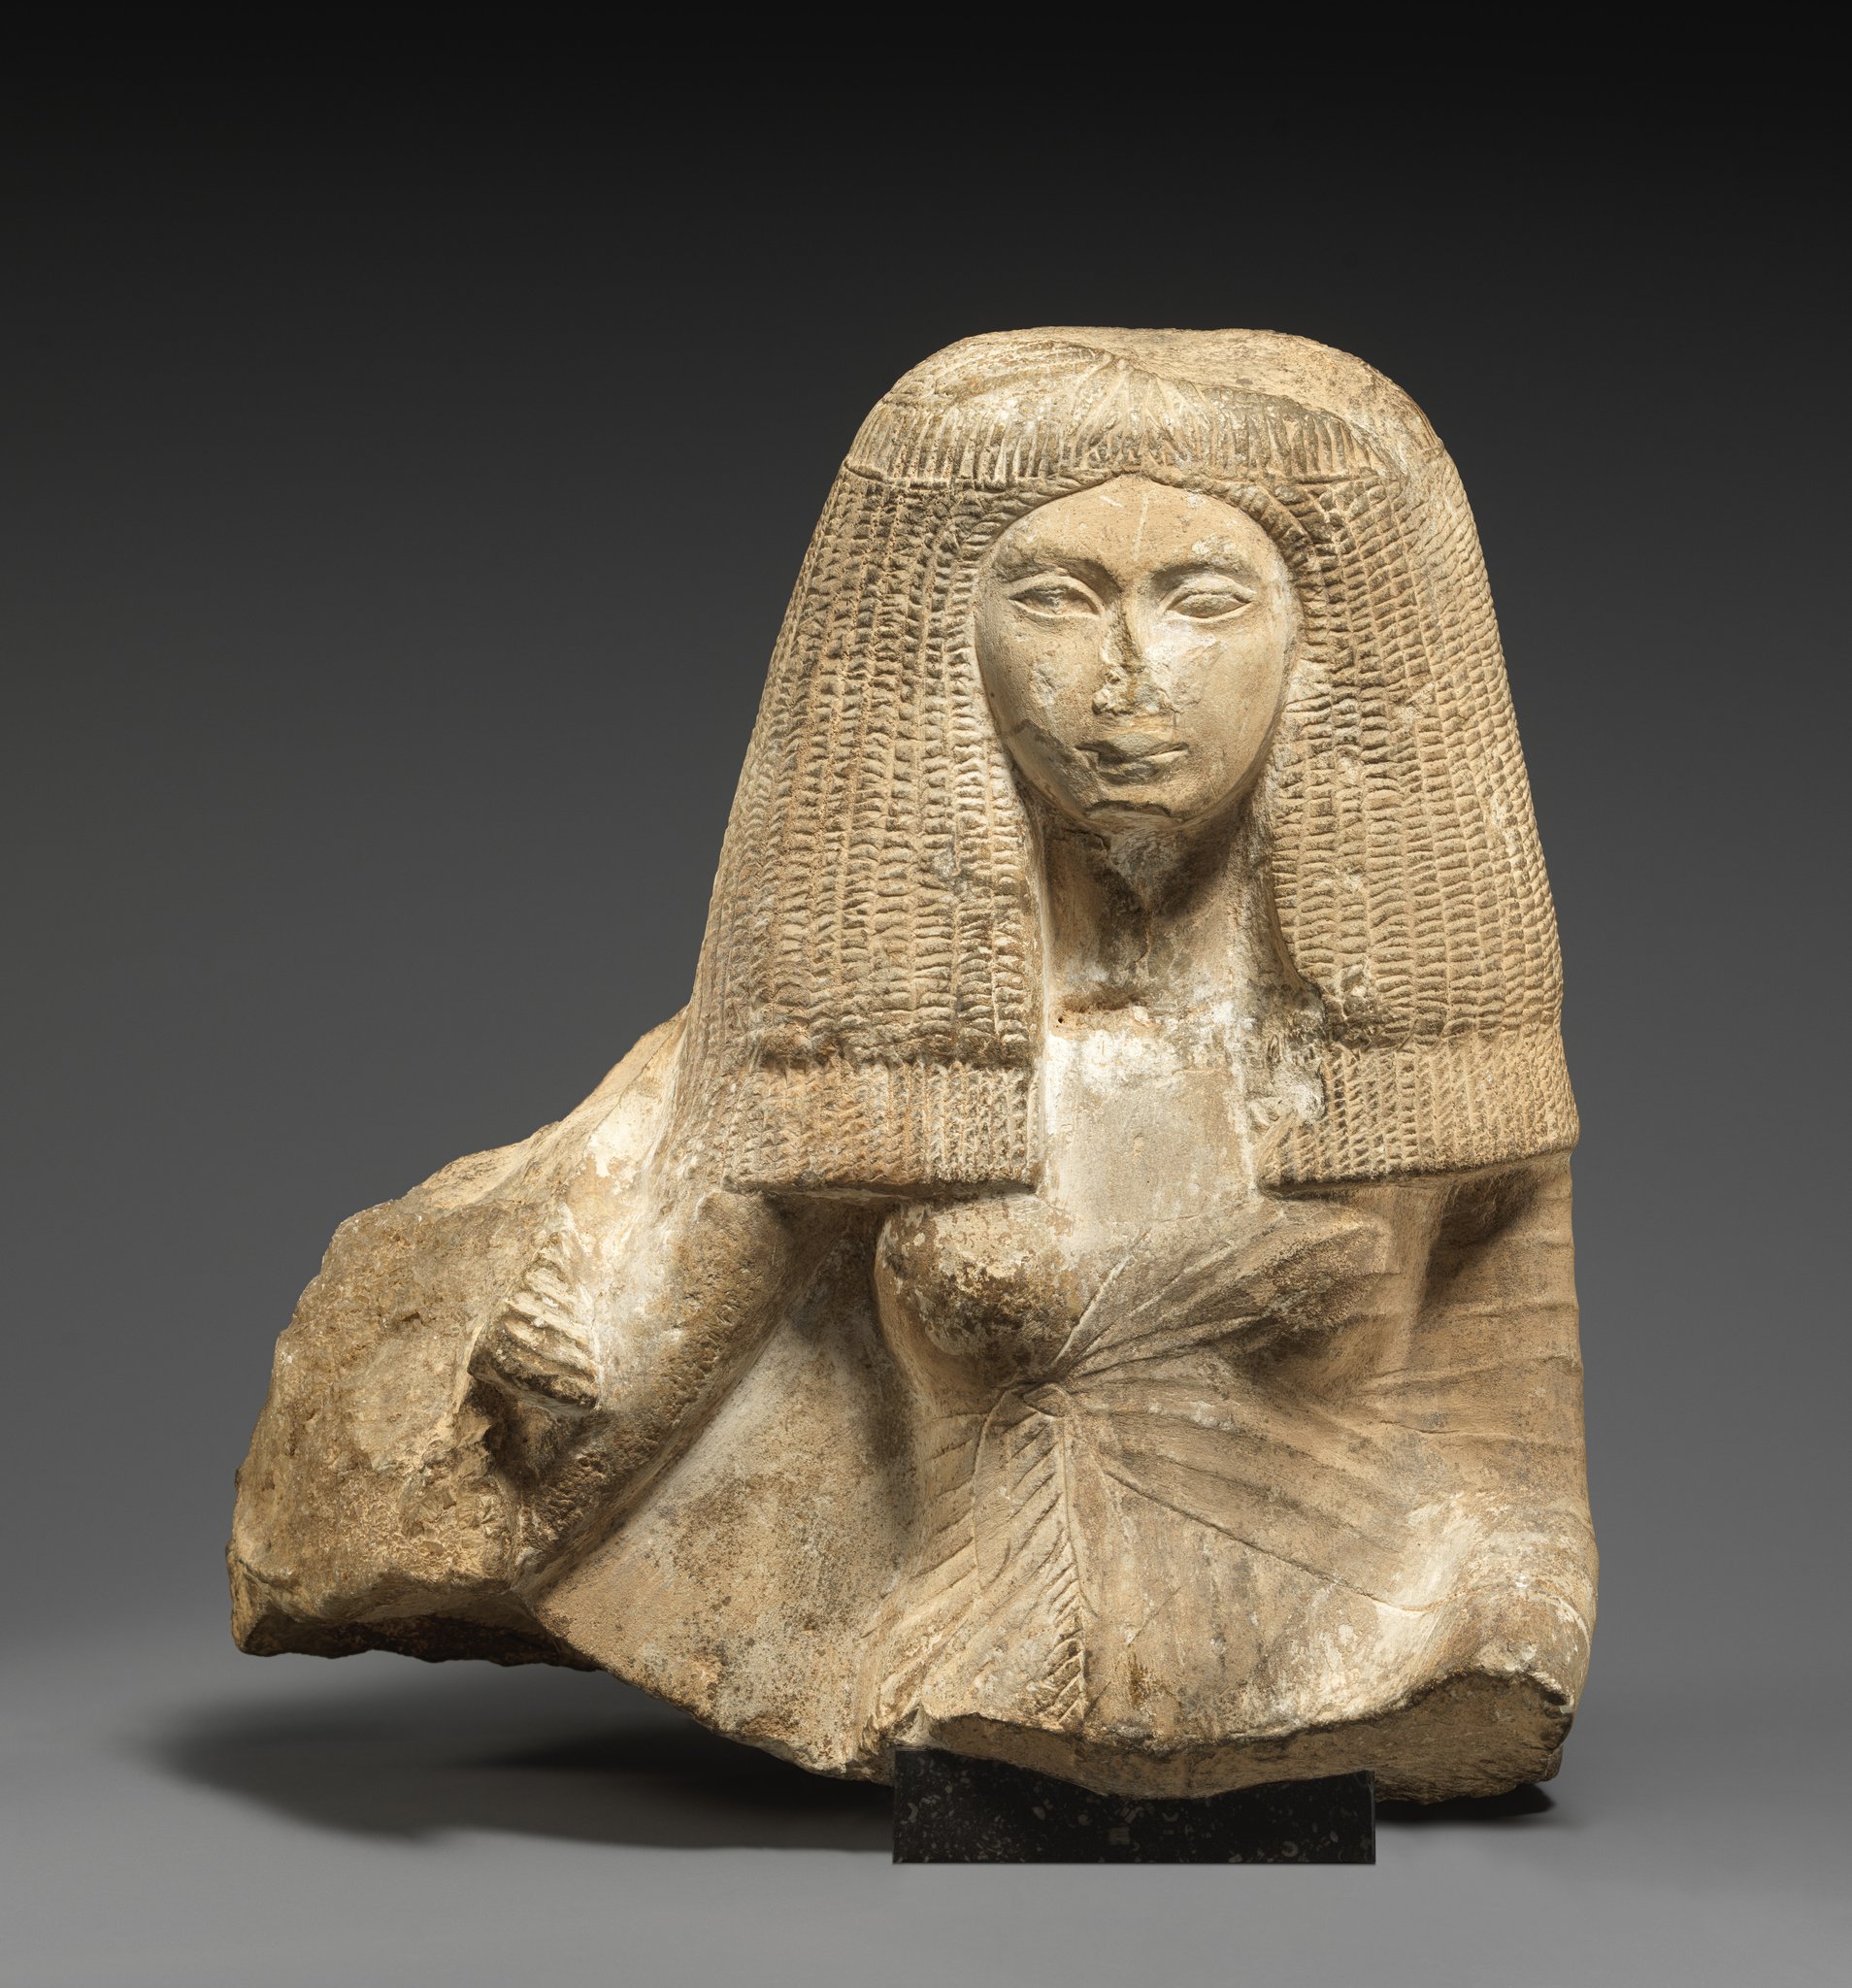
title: Unknown Woman from a Pair Statue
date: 1300-1250 BCE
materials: limestone, paint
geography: egypt